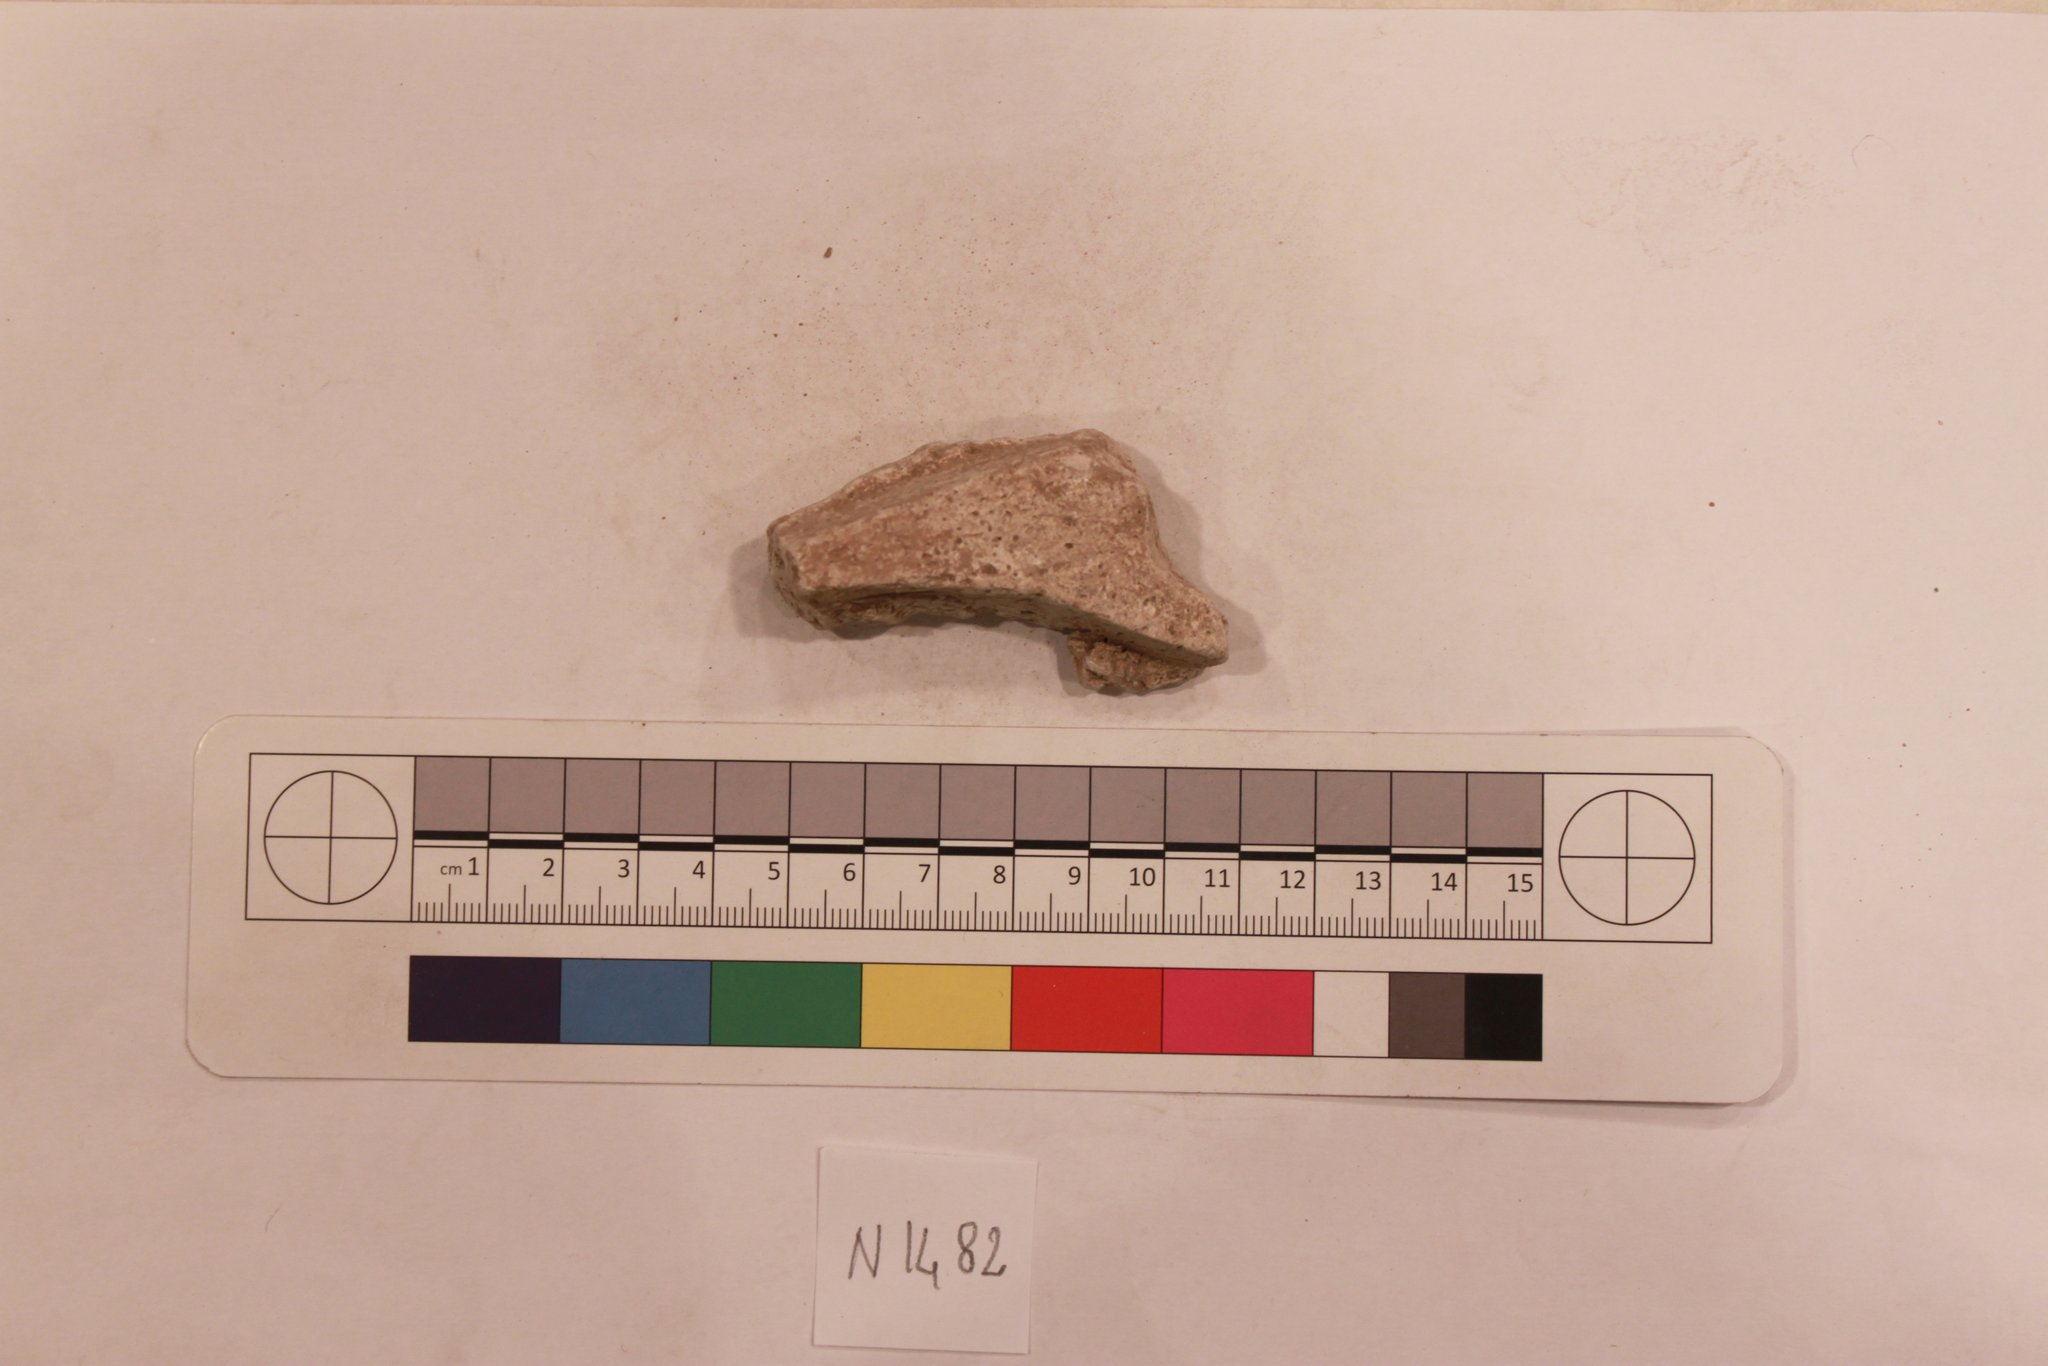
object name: fragment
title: Stucco Fragment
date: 701-1200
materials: plaster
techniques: carving, painting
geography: iran